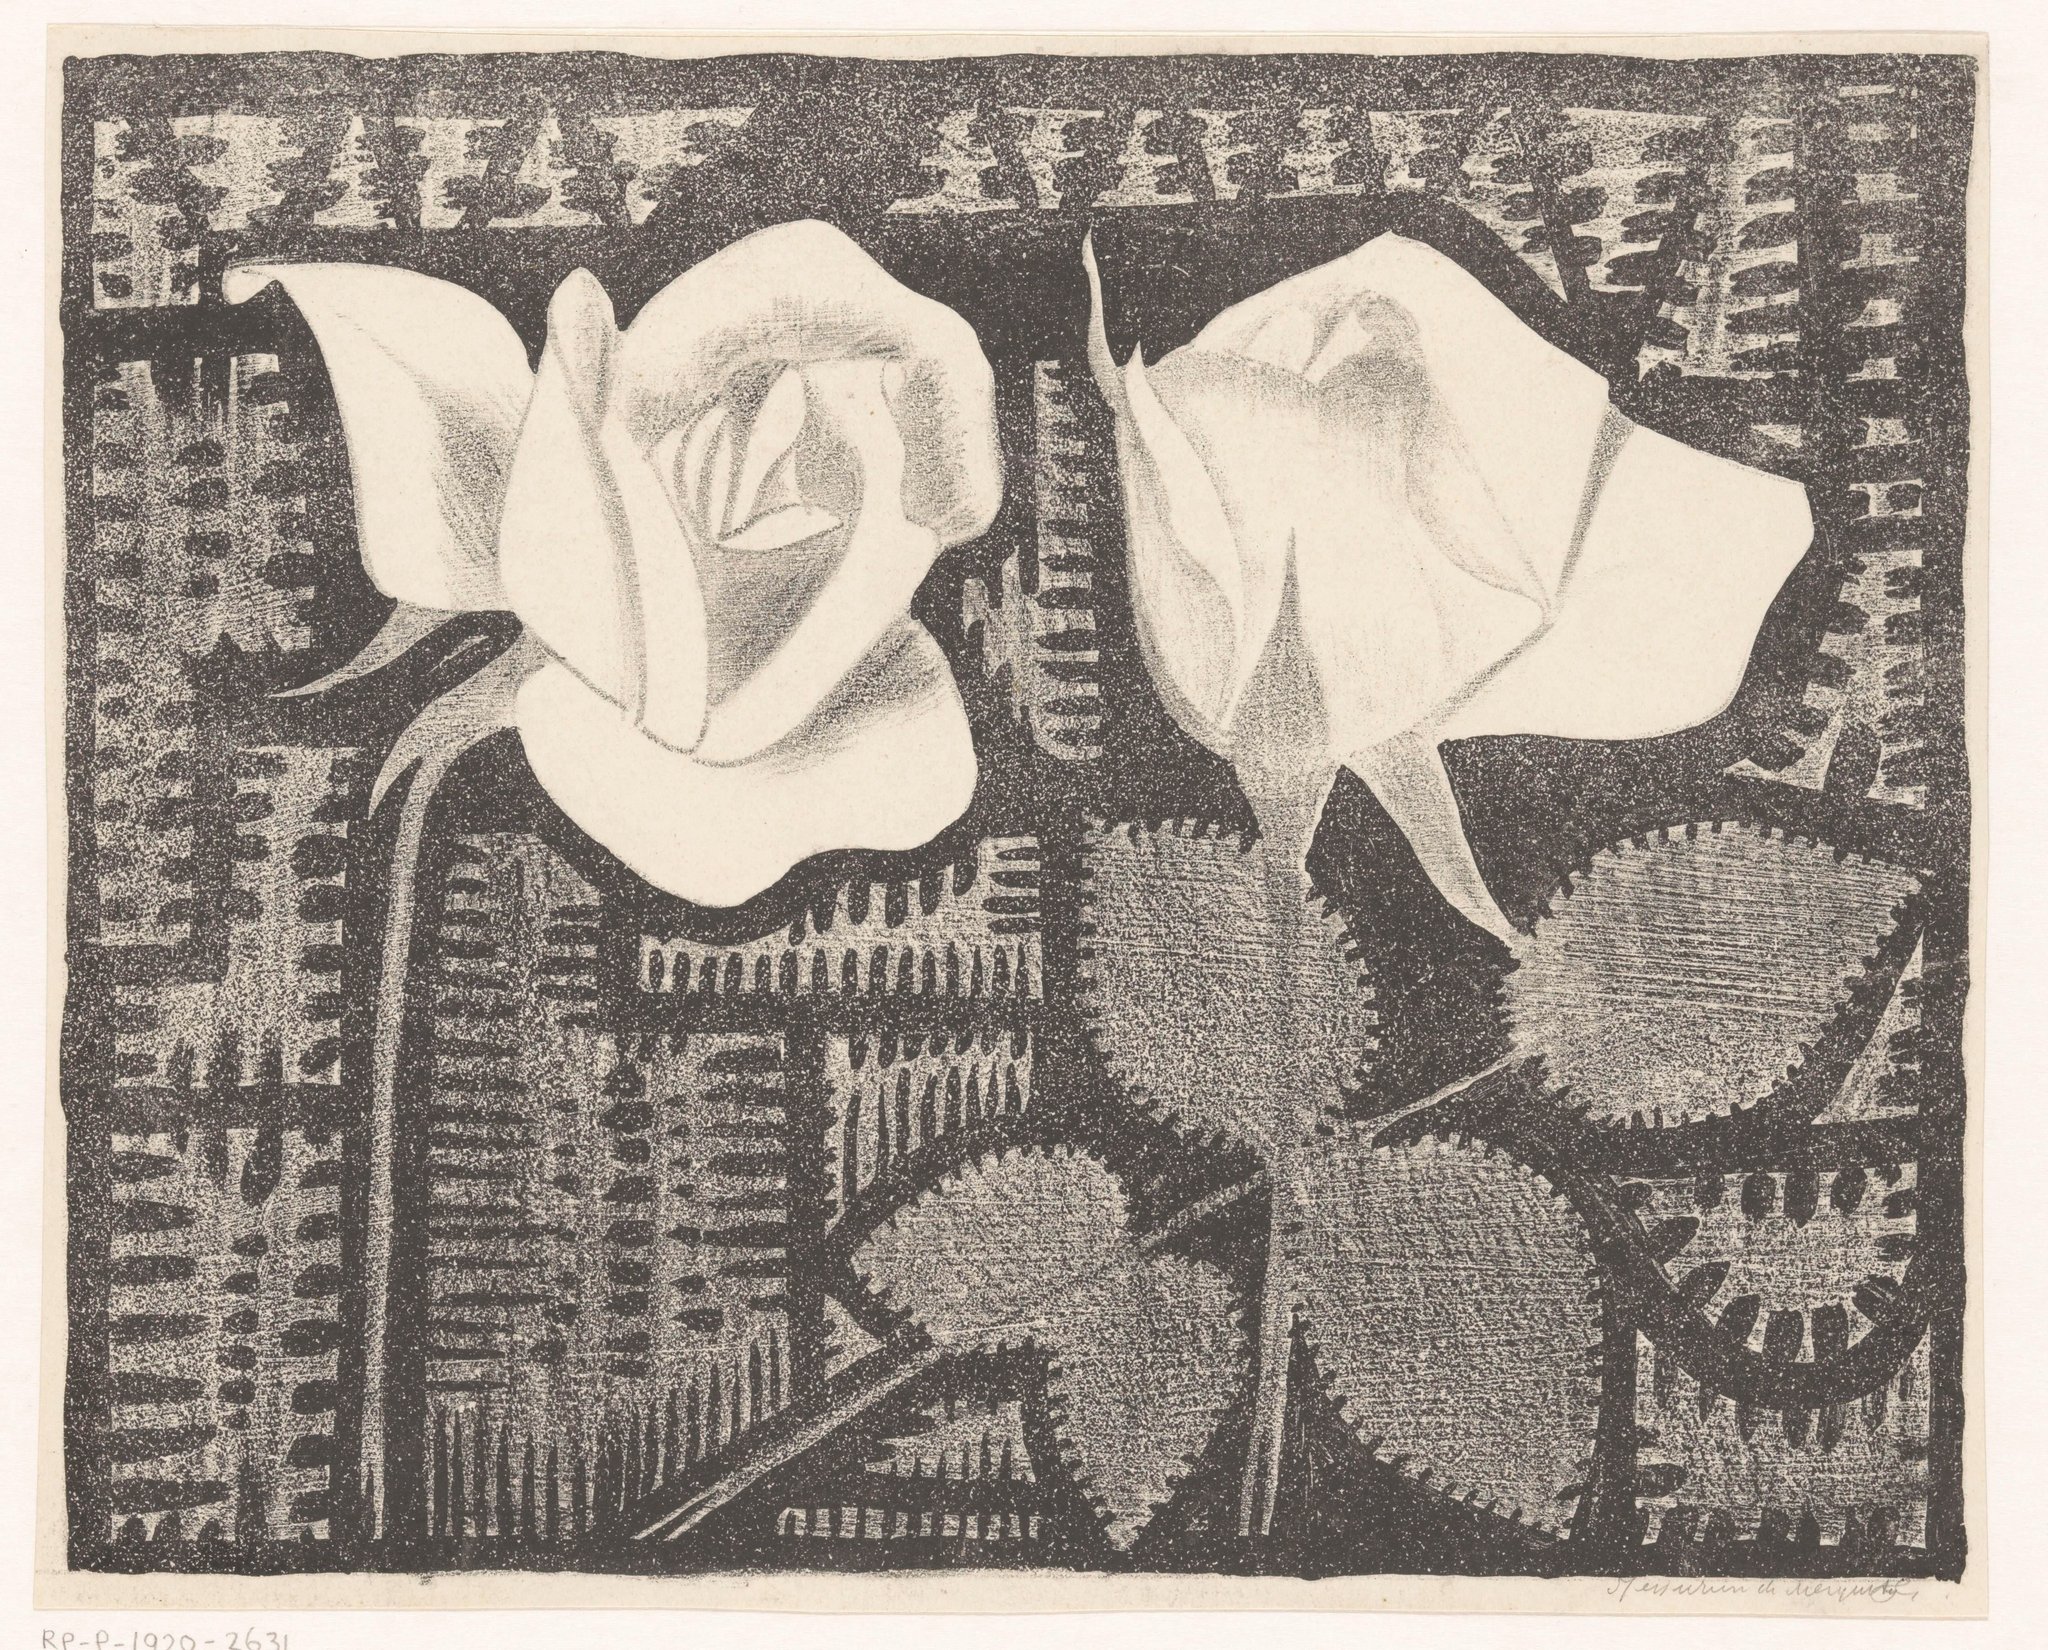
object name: print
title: Twee rozen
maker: samuel jessurun de mesquita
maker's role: draughtsman, print maker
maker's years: 1868-1944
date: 1920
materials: paper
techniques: lithograph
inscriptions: signature: ‘jessurun de mesquita’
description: Twee witte rozen en gebladerde tak tegen donkere achtergrond.